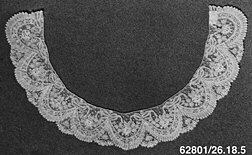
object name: collar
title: Collar lace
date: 1850-1875